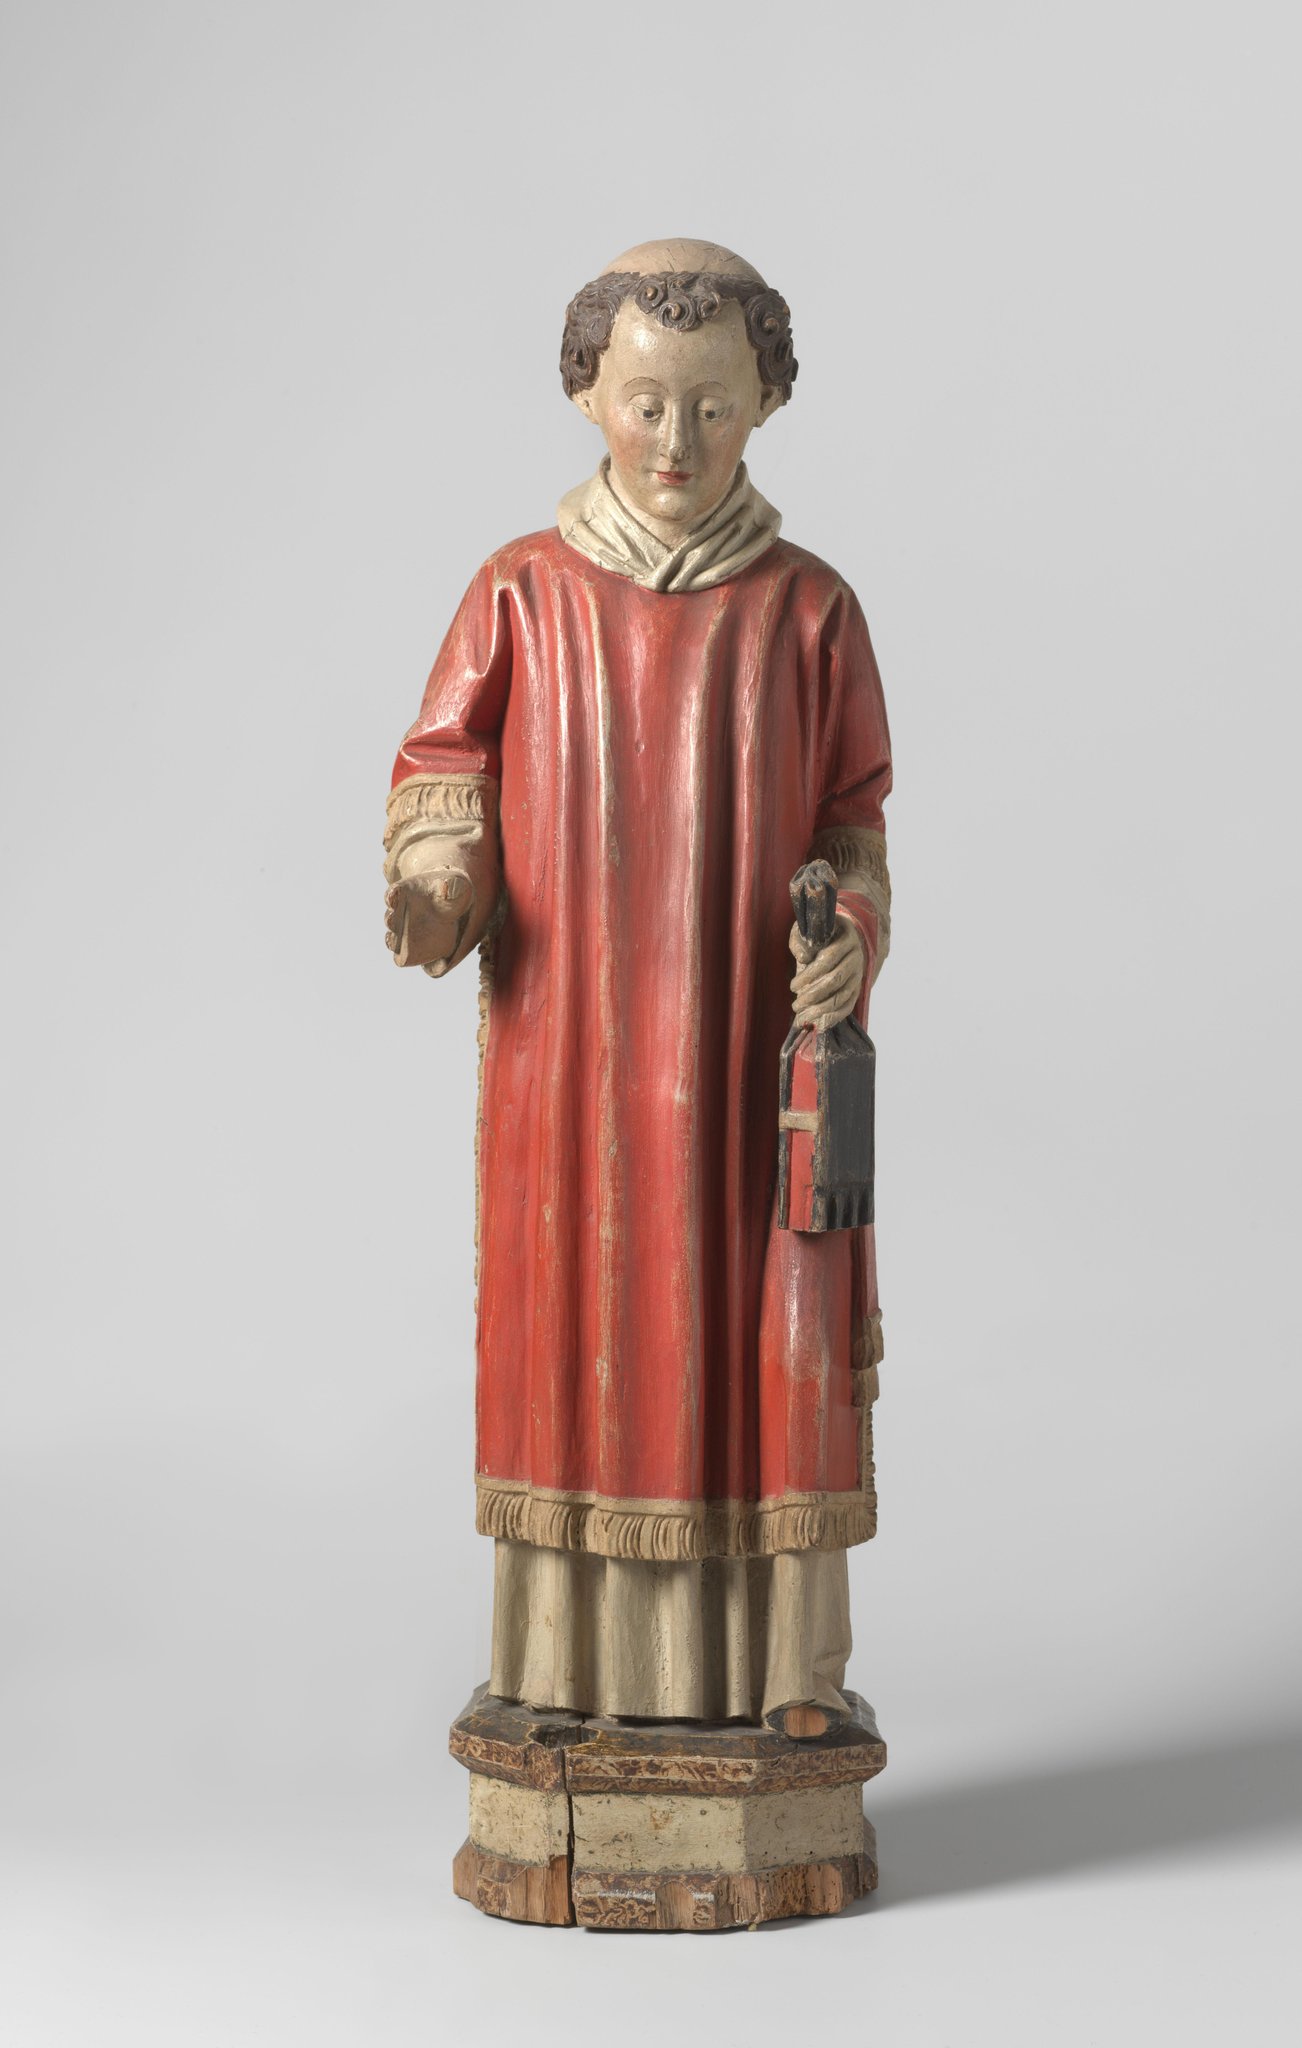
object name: sculpture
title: St Lawrence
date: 1480-1520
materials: wood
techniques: polychromy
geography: north brabant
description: Op een veelhoekig, geprofileerd voetstukje staat hij met het linkerbeen gebogen en met de blik schuin naar beneden gericht. De kop met grote kruinschering vertoont krullend haar. In de linkerhand draagt hij een boek aan de buidel, de rechter, waarin het attribuut ontbreekt, houdt hij voor zich uit. Hij is gekleed in dalmatiek, albe en amict, over de linkerpols hangt de manipel. Vooraan in het voetstuk een gat ter bevestiging van het attribuut.